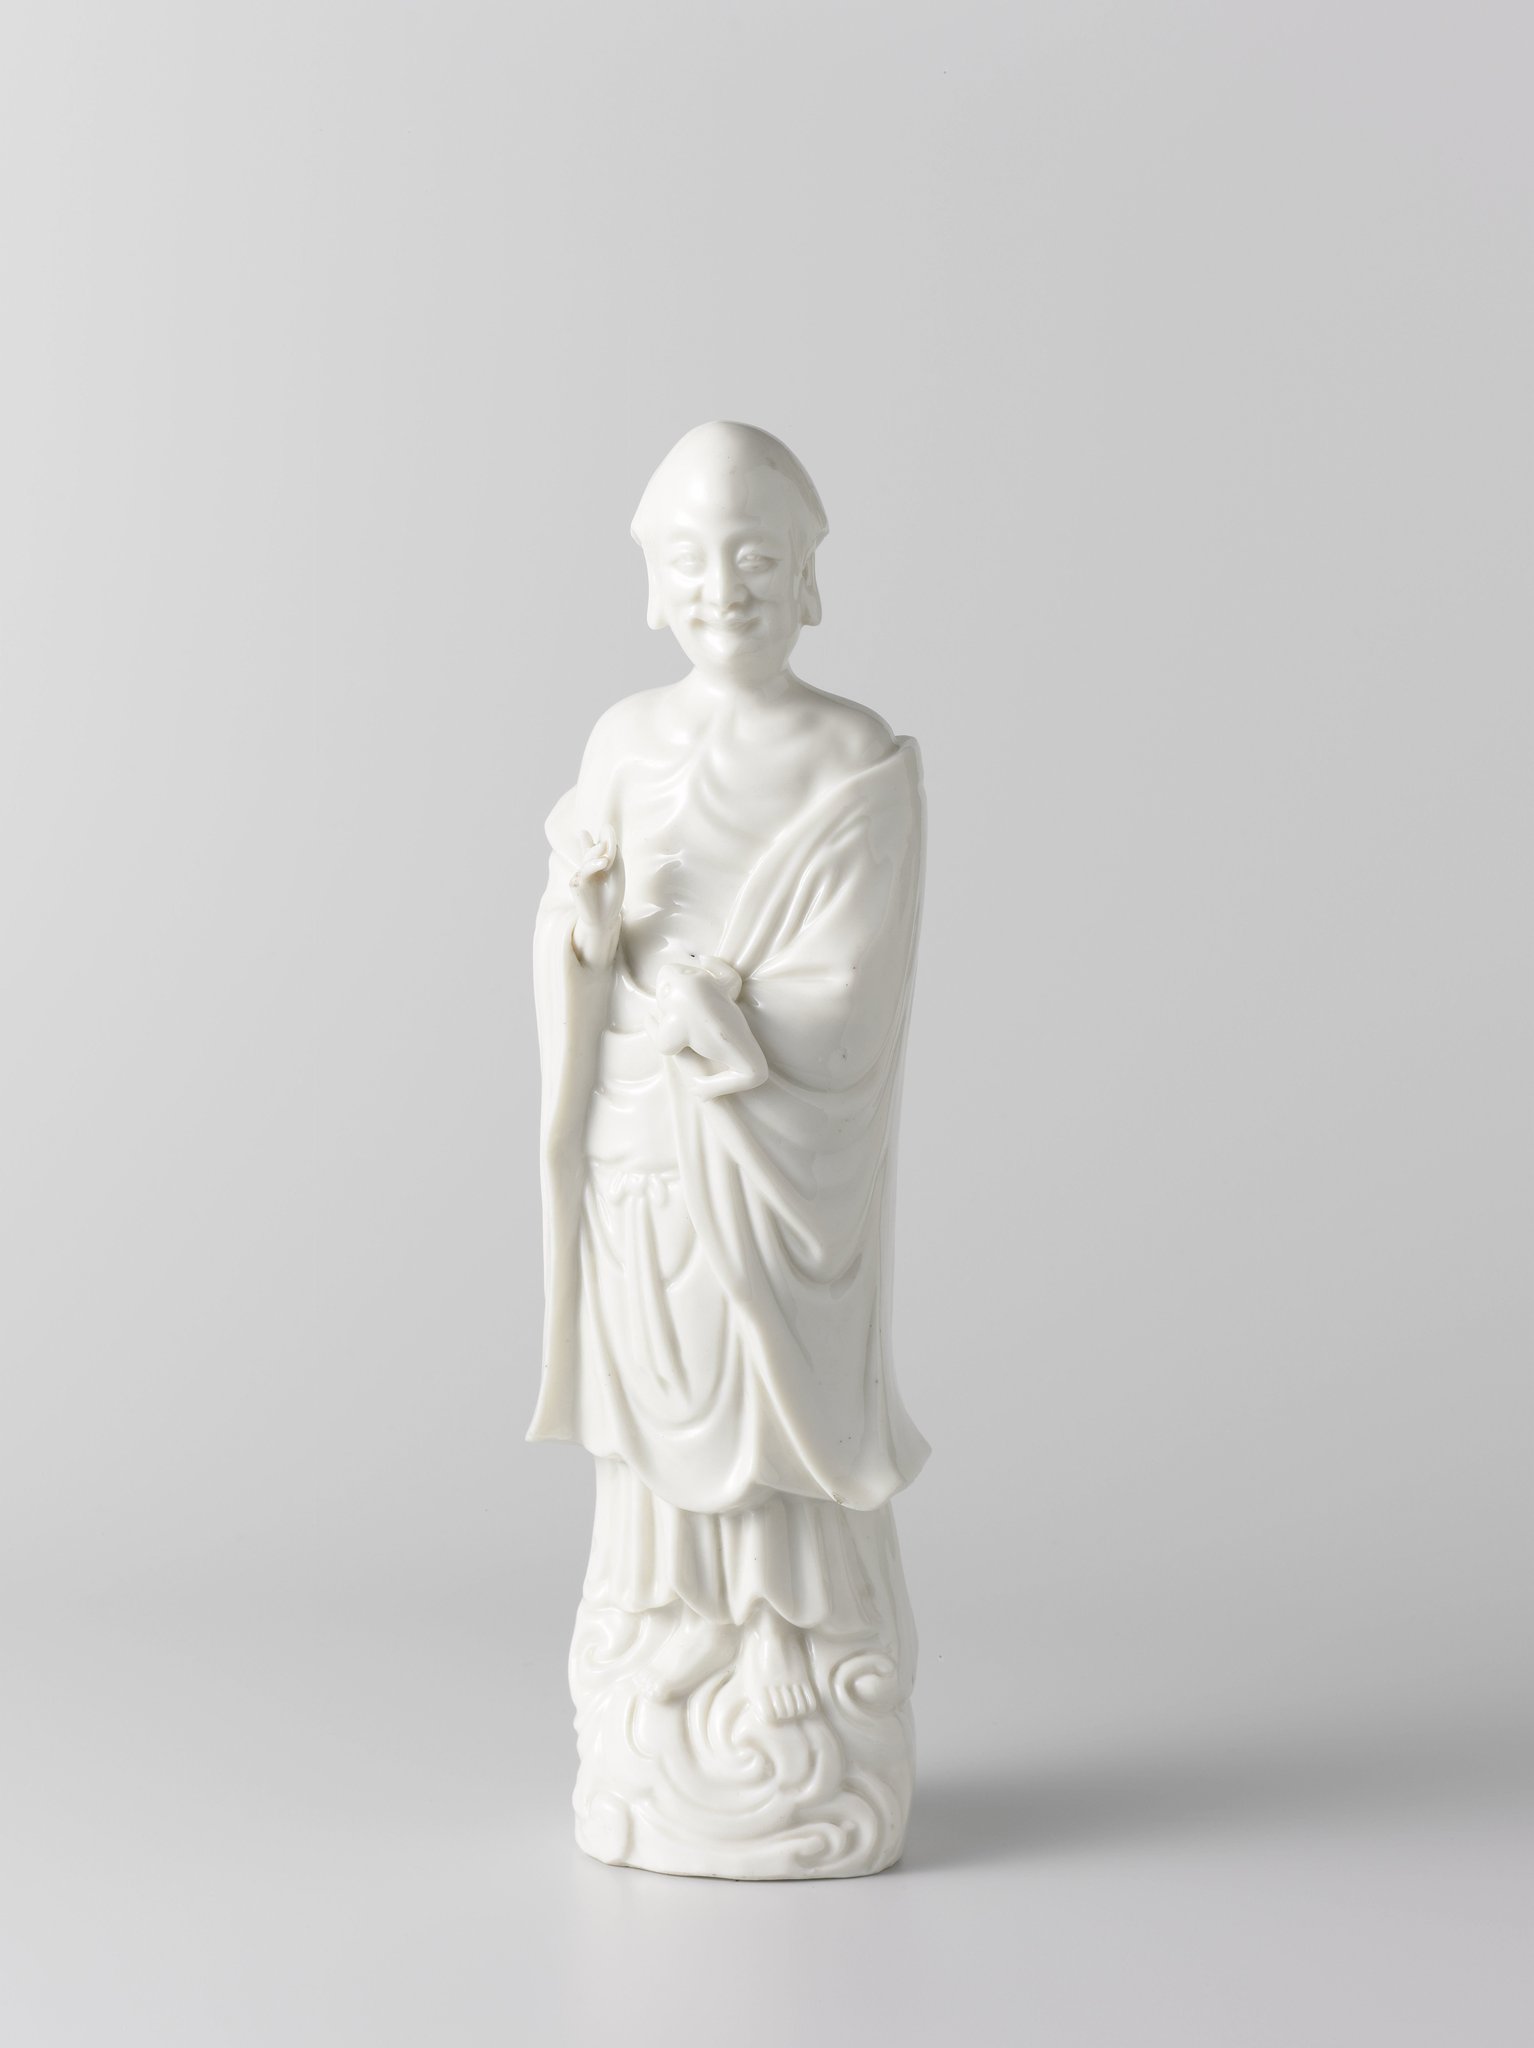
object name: figure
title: The immortal Liu Hai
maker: Anonymous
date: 1700-1724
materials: glaze, porcelain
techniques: firing, forming, vitrification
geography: dehua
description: Beeld van een staande figuur met in de rechterhand een stuk geld en op de linkerarm een kikker.